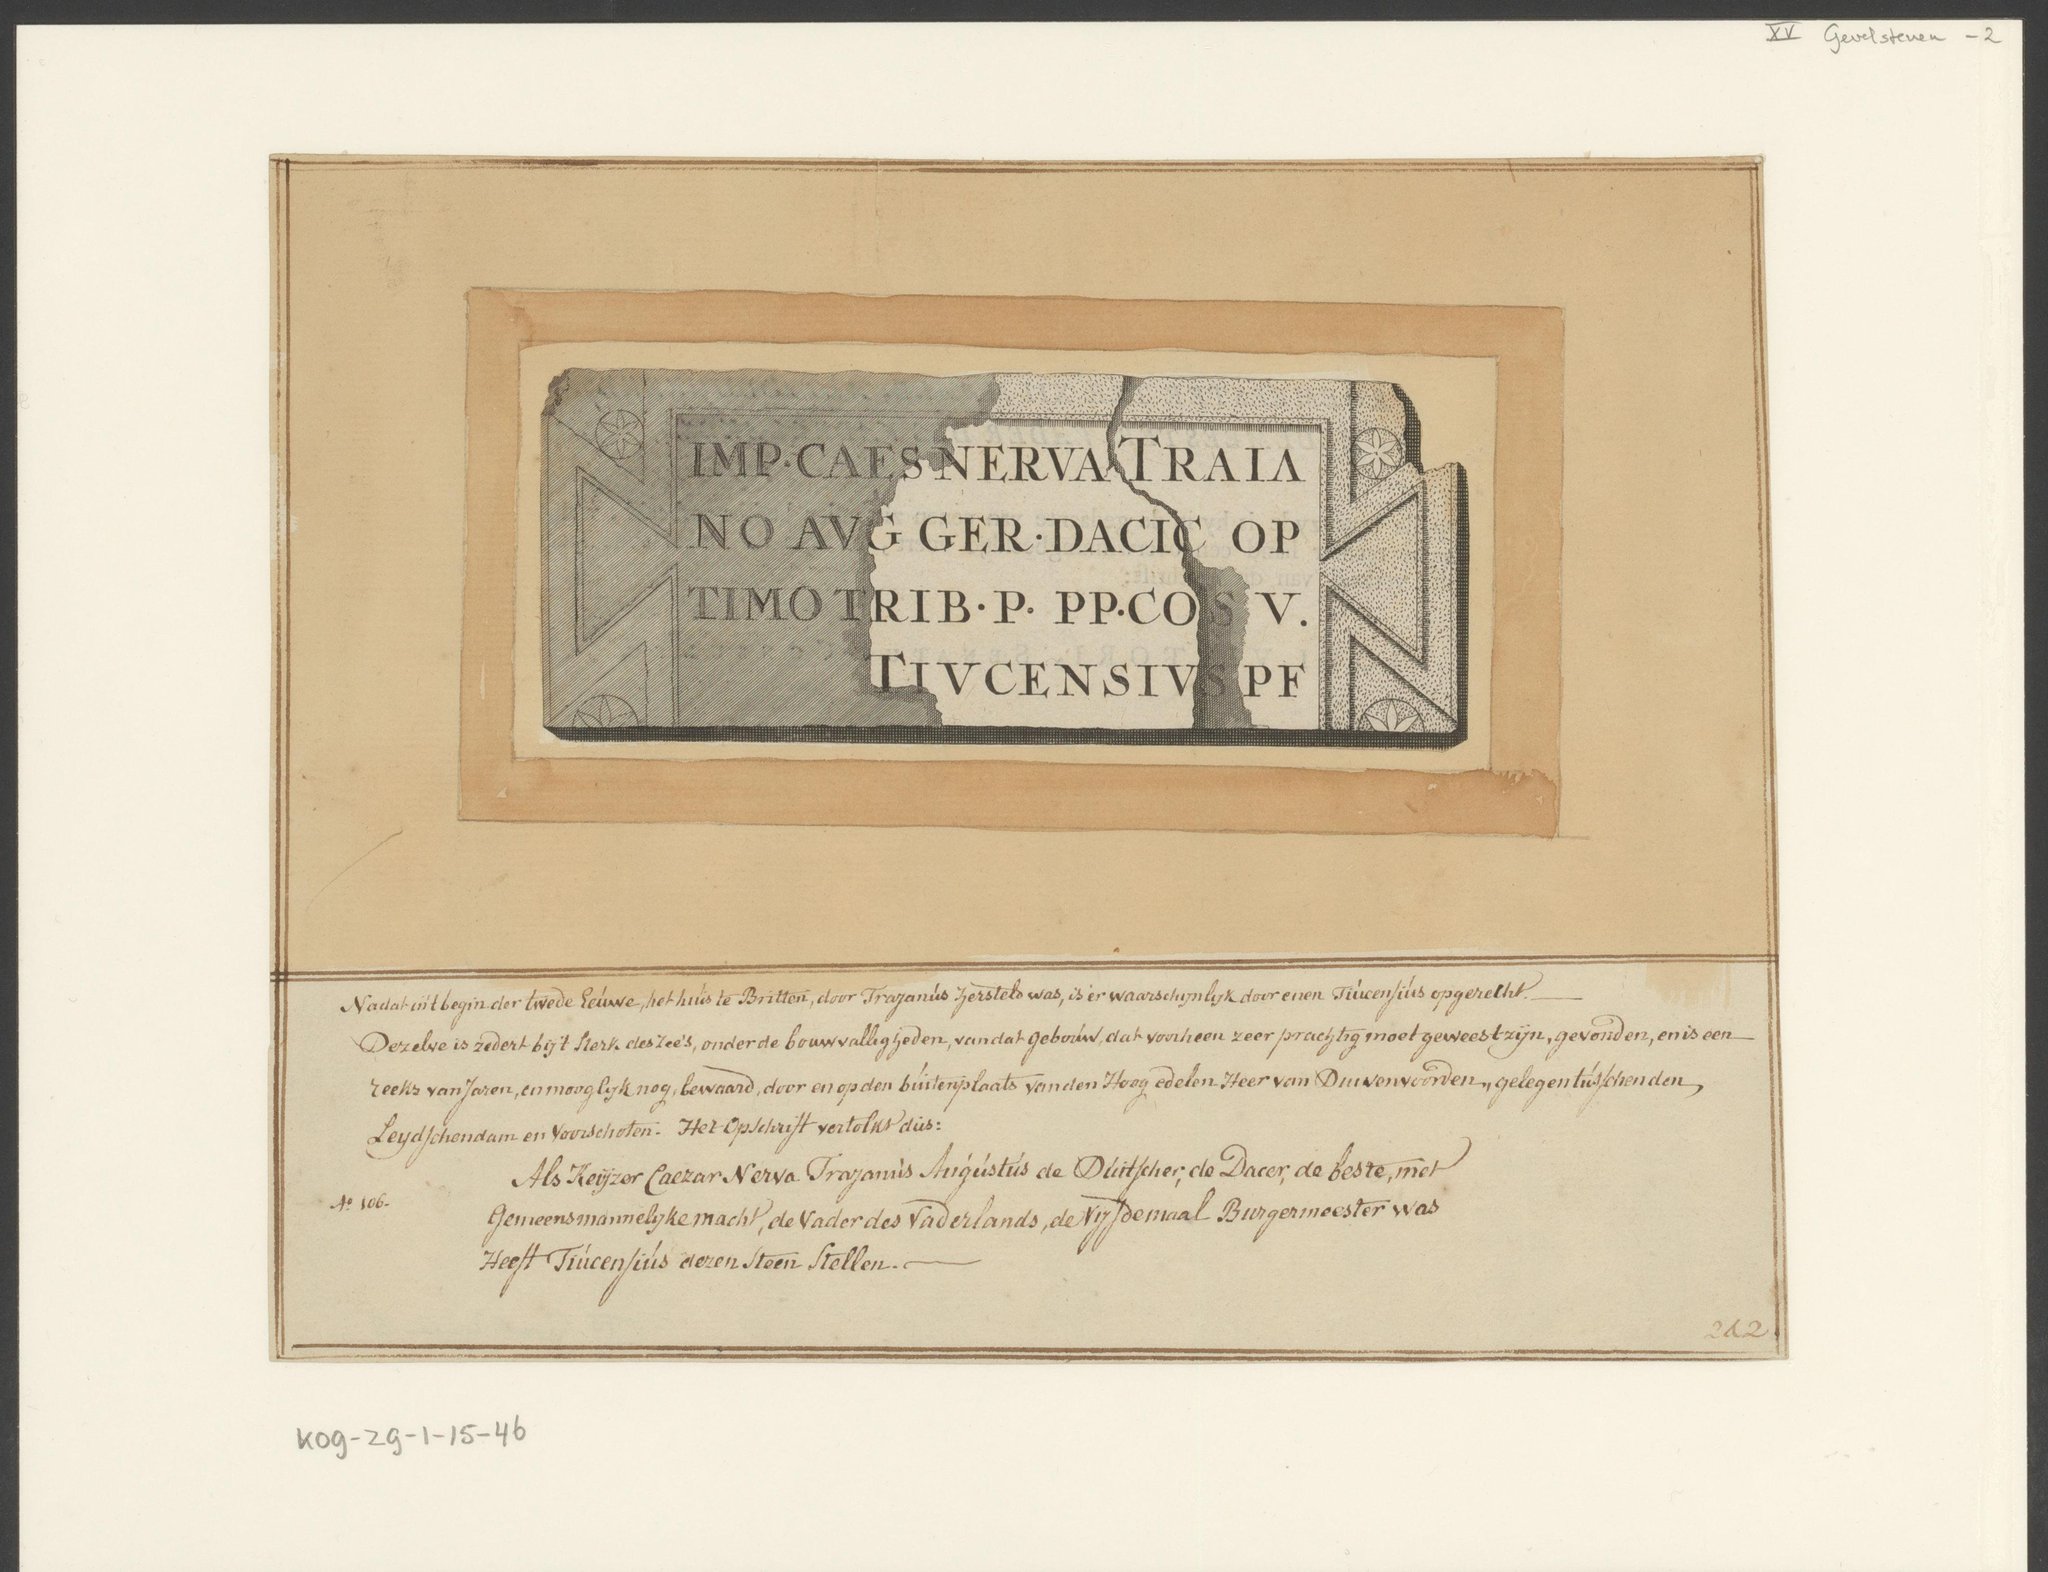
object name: print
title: Imp. Caes nerva Traia no aug ger. Dacic op timo trib.p. pp.cos v. tivcensius pf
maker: françois van bleyswijck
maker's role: draughtsman, print maker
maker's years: 1671-1746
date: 1734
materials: paper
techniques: engraving, writing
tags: extinct, 'historical' peoples (with name)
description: Prent uit: Loon, Gerard van. Aloude Hollandsche Histori der Keyzeren, Koningen, Hertogen en Graaven (...). Den Haag: Pieter de Hondt, 1734.